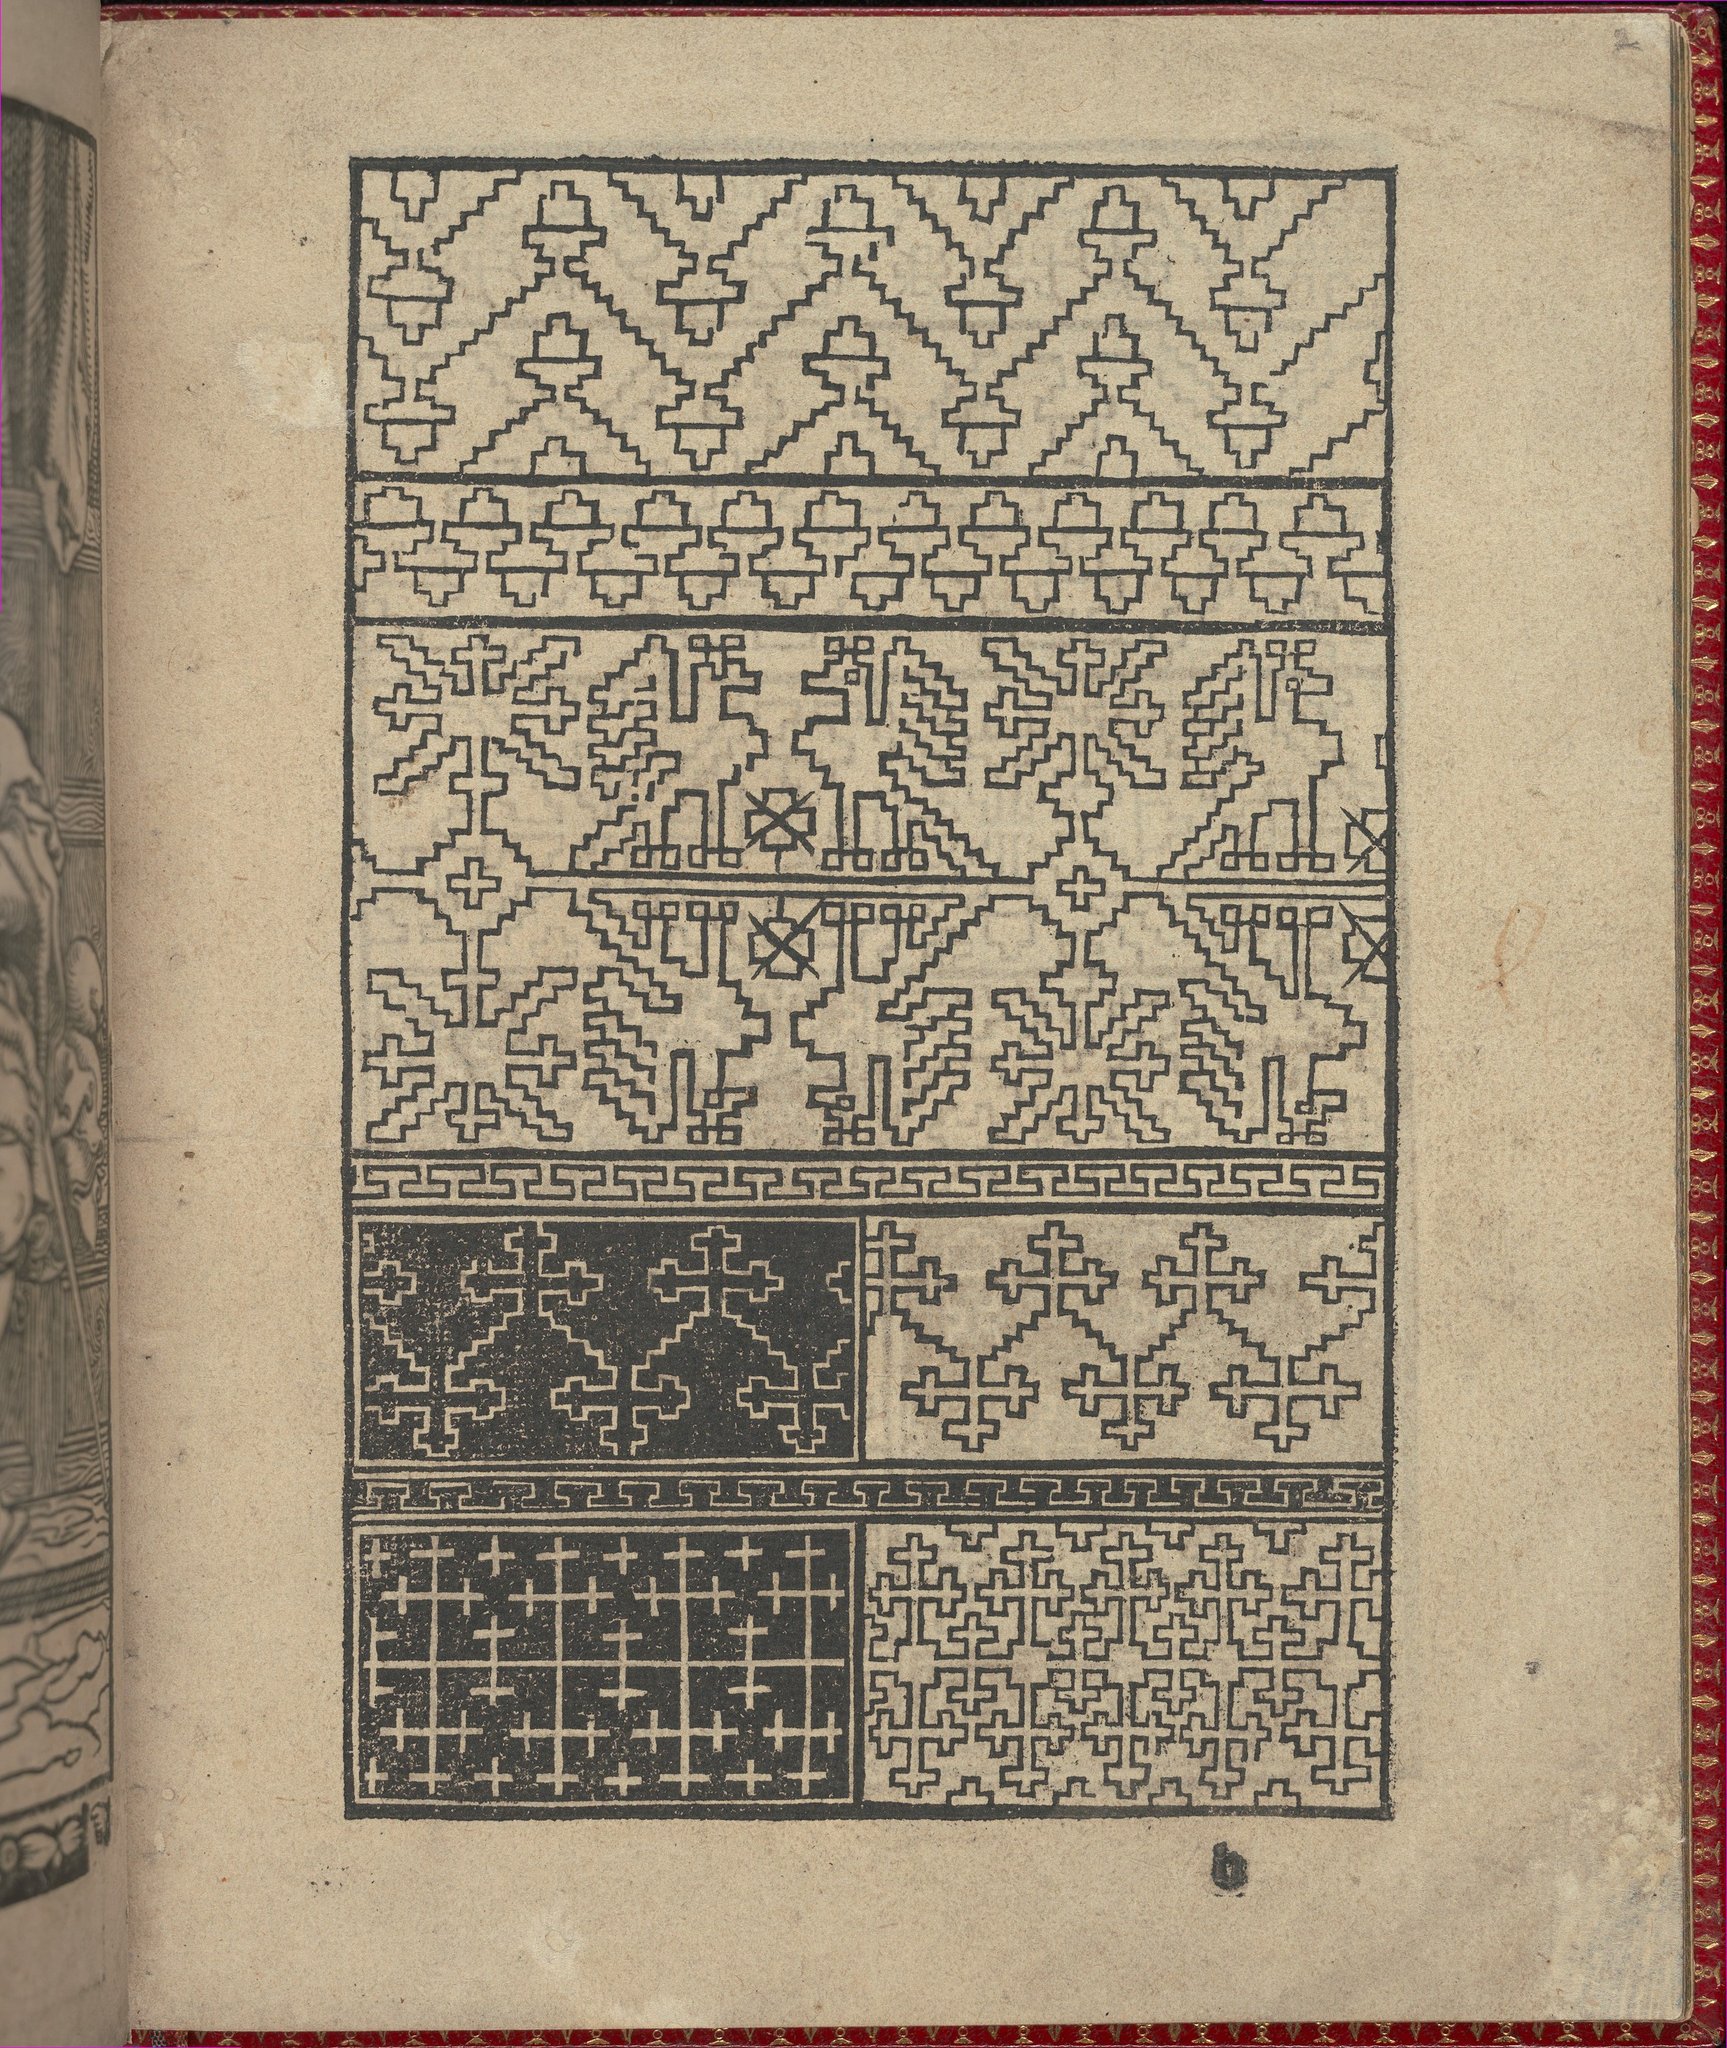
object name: book print ornament architecture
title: Ce est ung tractat de la noble art de leguille ascavoir ouvraiges de spaigne... page 2 (recto)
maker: willem vosterman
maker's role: printer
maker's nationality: netherlandish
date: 1527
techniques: woodcut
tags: ornament